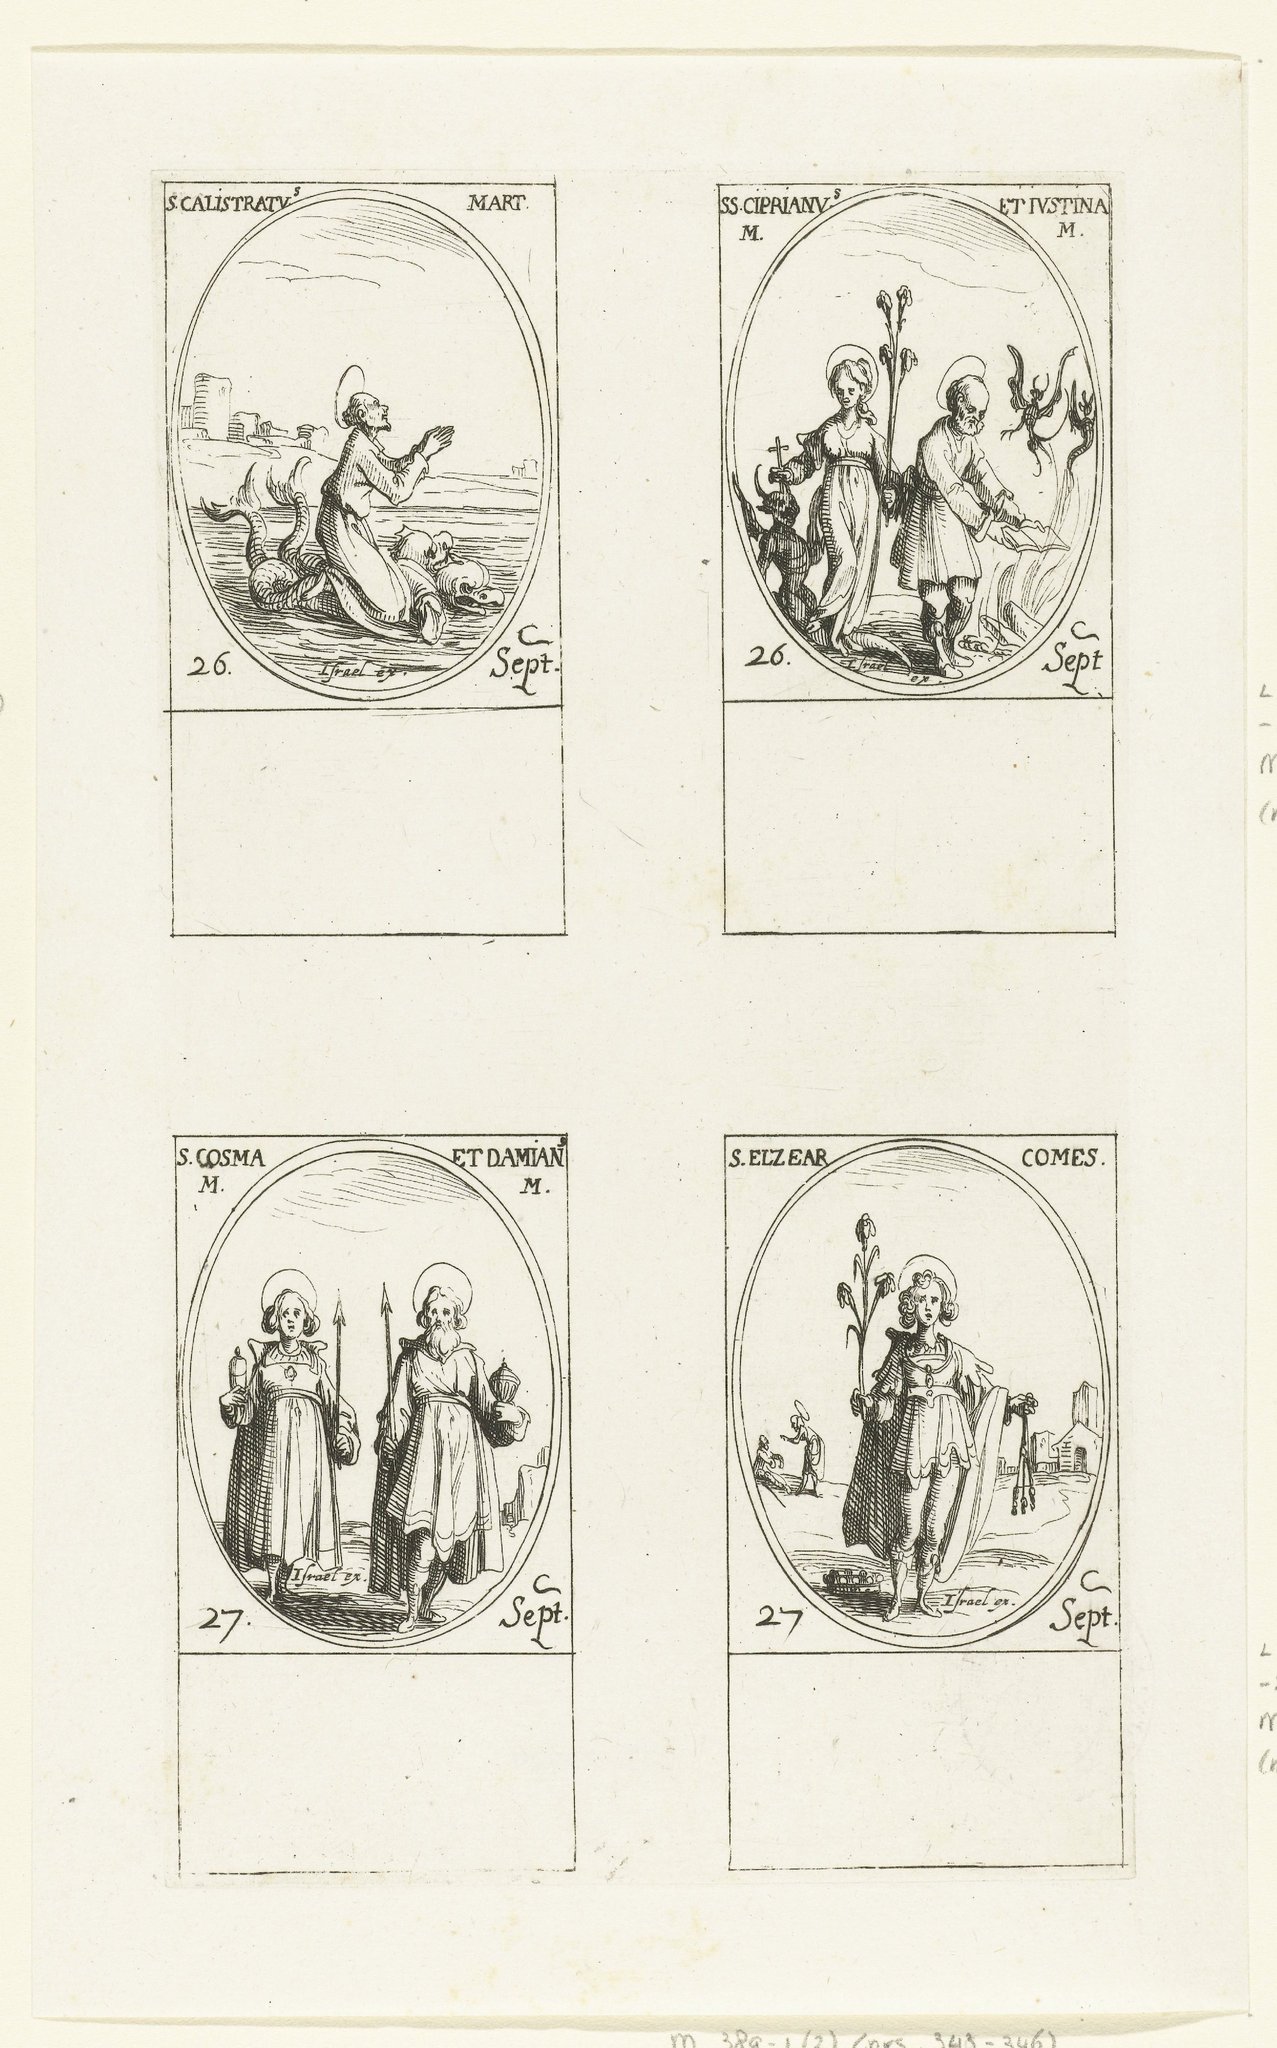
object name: print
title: Heilige Callistratus, Heilige Cyprianus van Antiochië en Heilige Justina van Nicomedië, Heilige Cosmas en Heilige Damianus, Heilige Eleazar van Sabran (26-27 september)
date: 1632-1636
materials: paper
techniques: etching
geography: paris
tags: male saints (with name), the twin-brothers cosmas and damian(us), martyrs and physicians; possible attributes: box of ointment, cap, gown, lancet, pestle and mortar, urinal, the martyrs justina and cyprian(us) of nicomedia (antioch); possible attributes: palm, sword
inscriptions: collector's mark: Lugt 240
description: Blad met vier ovale voorstellingen, elk met opschrift en datum in het Latijn: linksboven de Heilige Callistratus varend op twee dolfijnen, rechtsboven de Heilige Cyprianus van Antiochië en de Heilige Justina van Nicomedië met duivels om zich heen, linksonder de Heilige Cosmas en de Heilige Damianus als echtpaar (!) met elk een pijl in de hand, rechtsonder de Heilige Eleazar van Sabran met een lelie in de hand en een kroon bij zijn voeten. Deze prent is onderdeel van een serie prenten met voorstellingen van de heiligen en de christelijke feestdagen van het jaar. Er zijn steeds vier scènes van één plaat op één blad gedrukt. Inclusief bijbehorend titelblad en frontispice gaat het in totaal om 124 platen (490 voorstellingen). De drie platen met de laatste 12 scènes (de veranderlijke christelijke feestdagen) zijn in de derde staat versneden tot 12 kleine plaatjes, en met een apart titelblad uitgegeven.